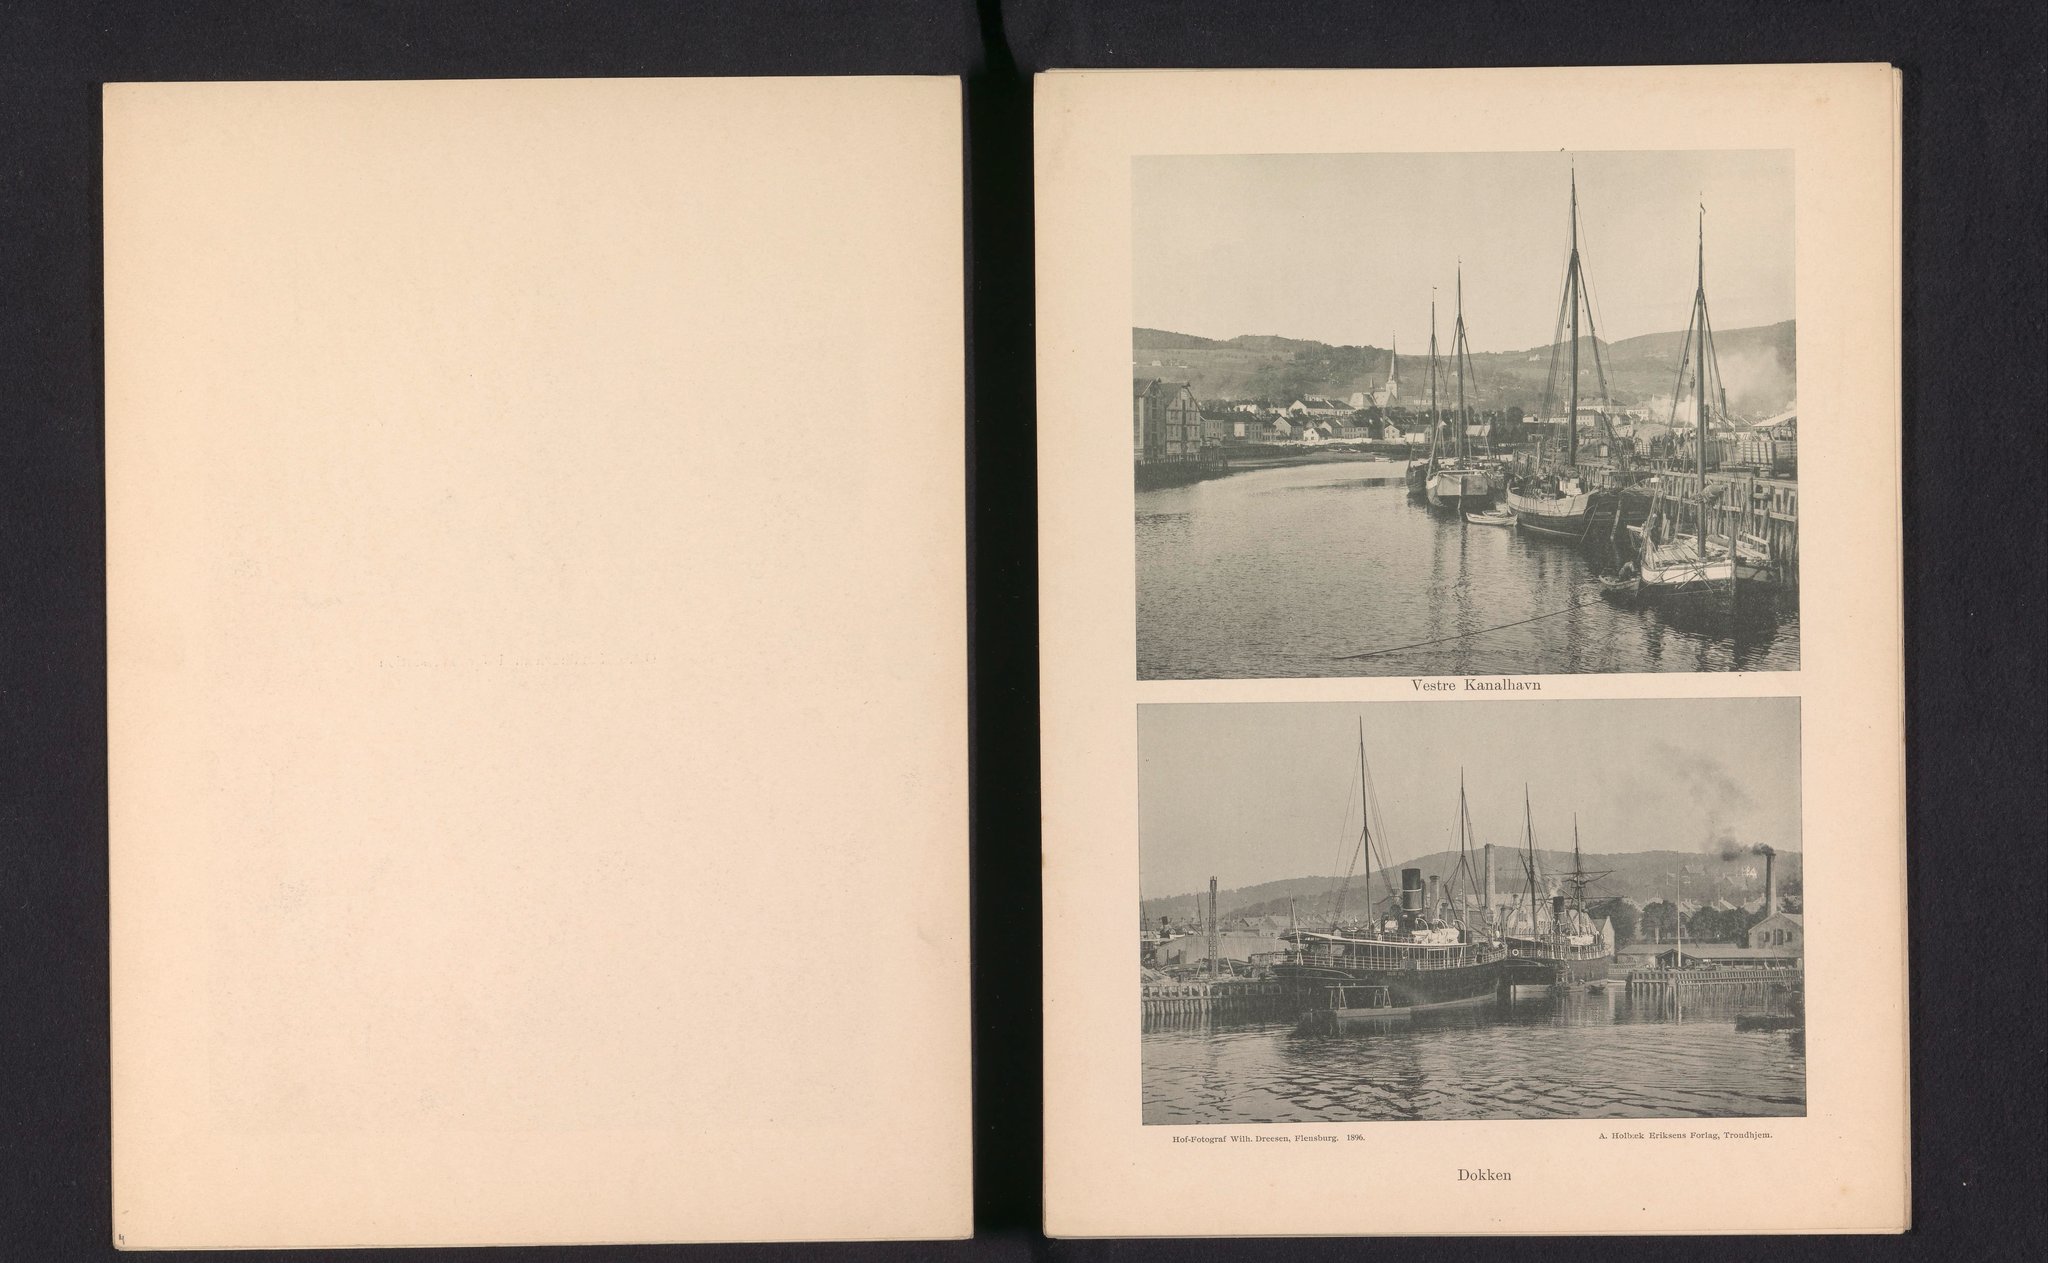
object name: photomechanical print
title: Vestre Kanalhavn Dokken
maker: wilhelm dreesen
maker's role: fotograaf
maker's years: 1840-1926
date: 1896-1897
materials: paper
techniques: photograph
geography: trondheim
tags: harbour, ships (in general), dry-dock, floating-dock